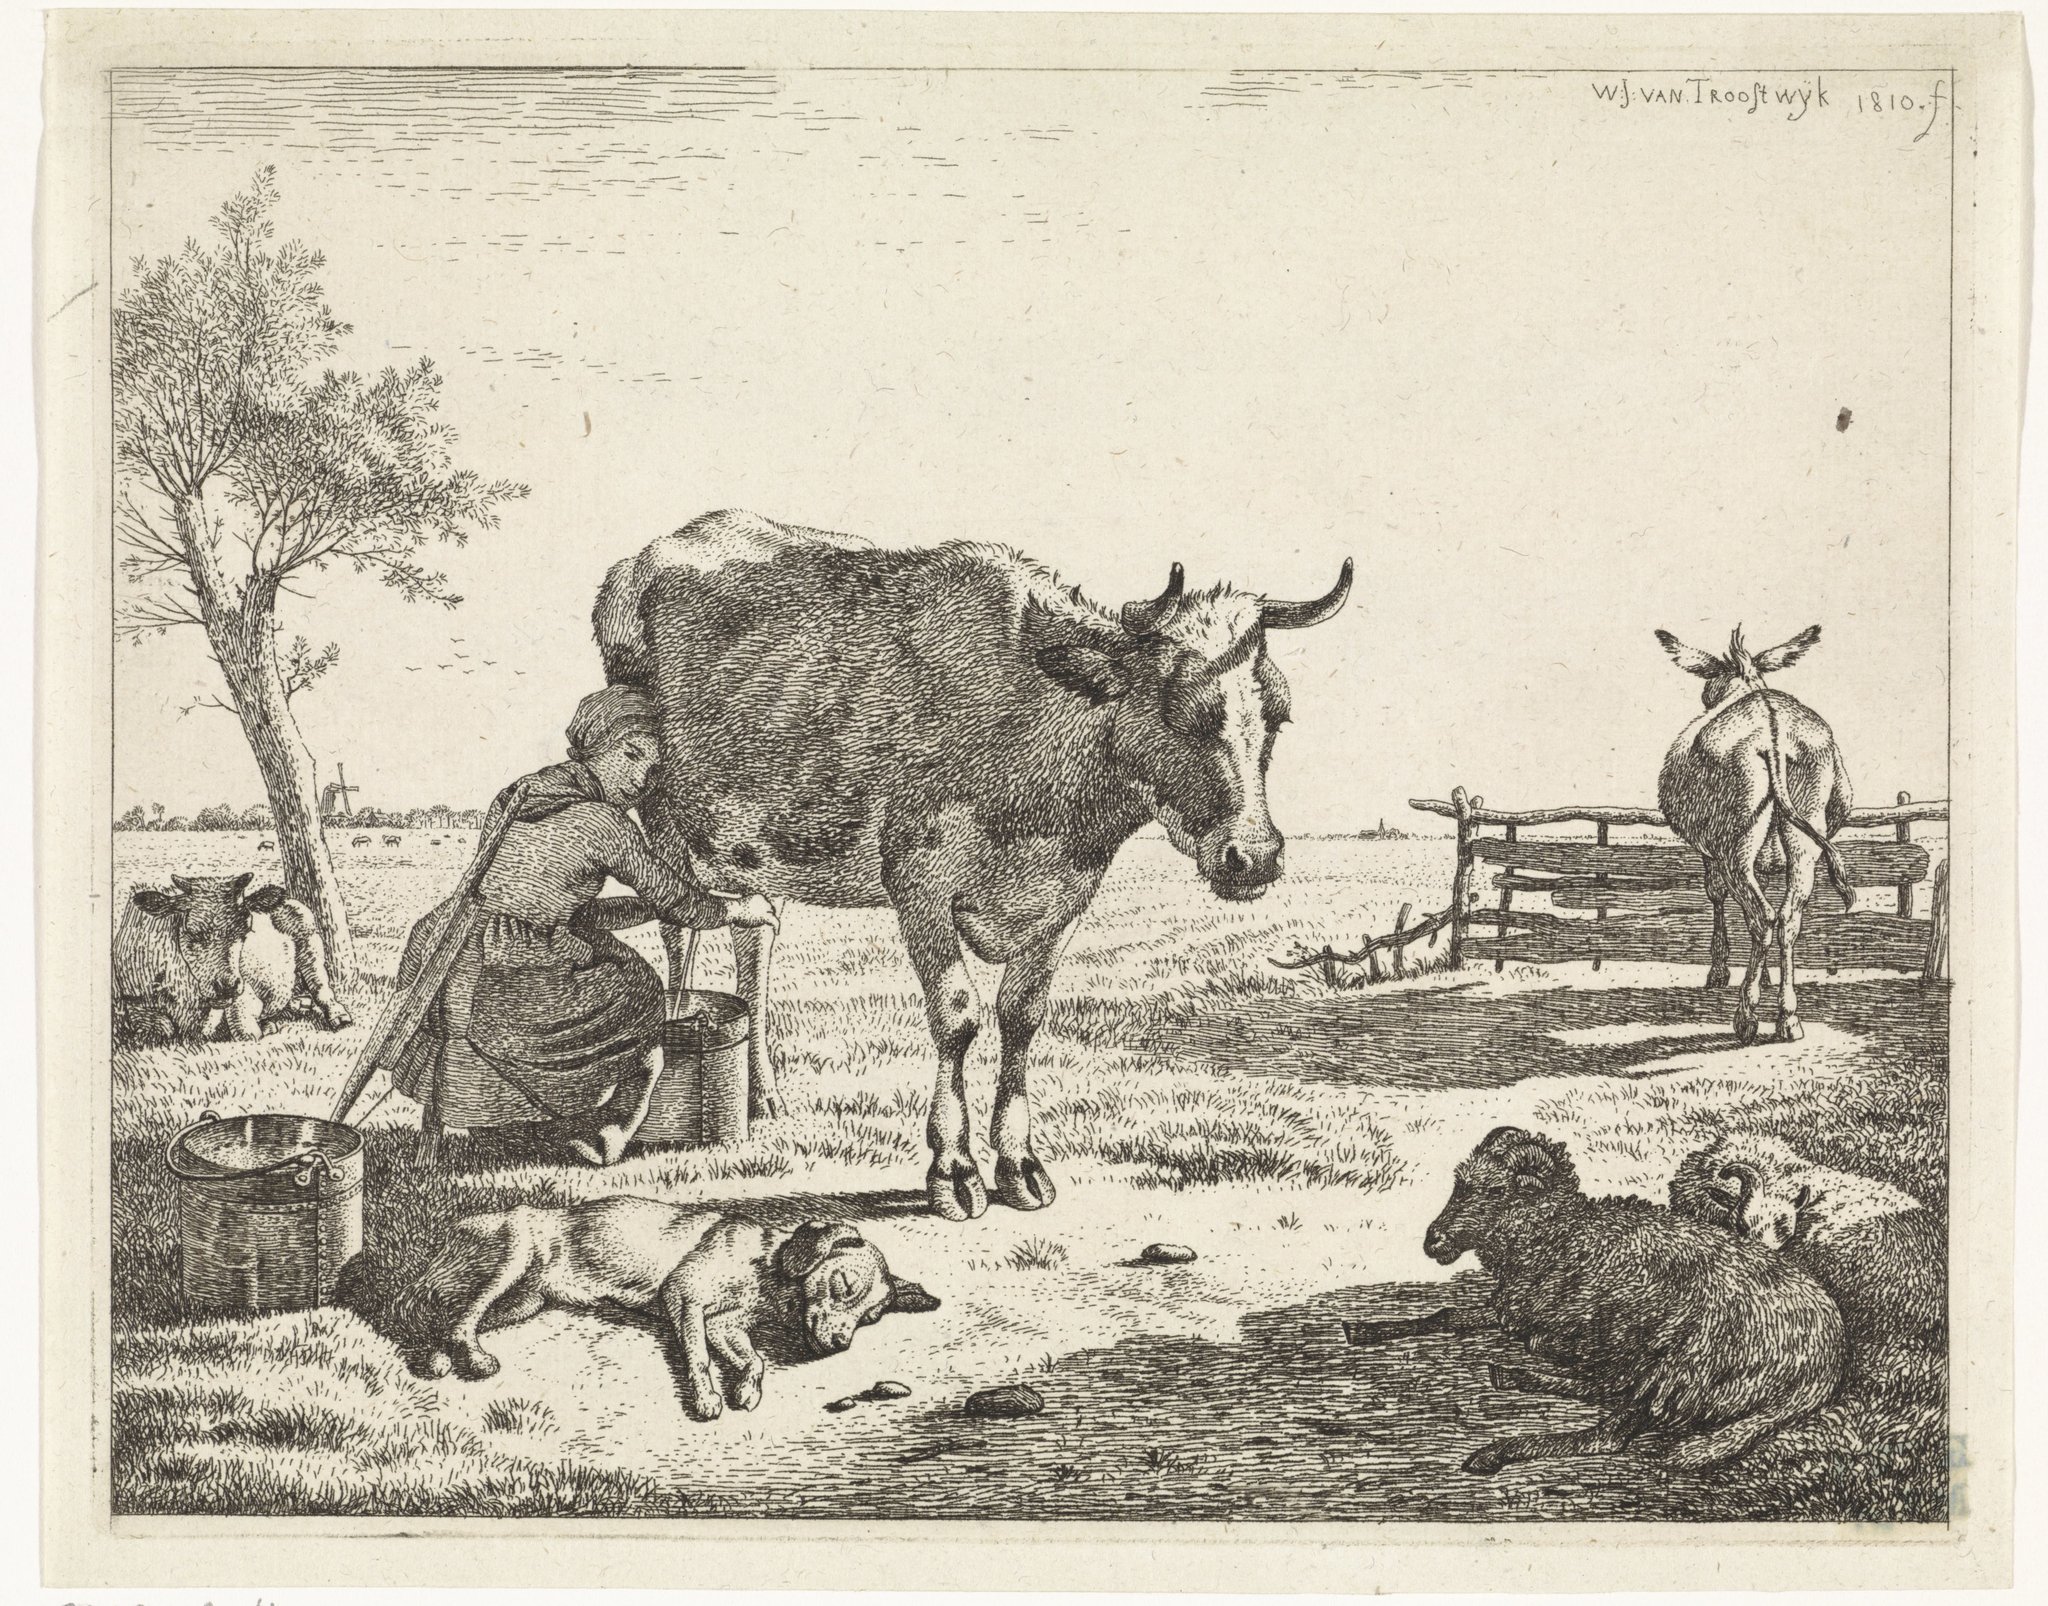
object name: print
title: Melkmeid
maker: wouter johannes van troostwijk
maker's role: draughtsman, painter, print maker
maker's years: 1782-1810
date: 1810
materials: paper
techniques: etching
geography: amsterdam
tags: milkmaid, milking, dog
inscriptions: collector's mark: Lugt 2165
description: In een weiland melkt een vrouw een koe. Op de voorgrond ligt een hond te slapen. Rechts een liggend schaap.